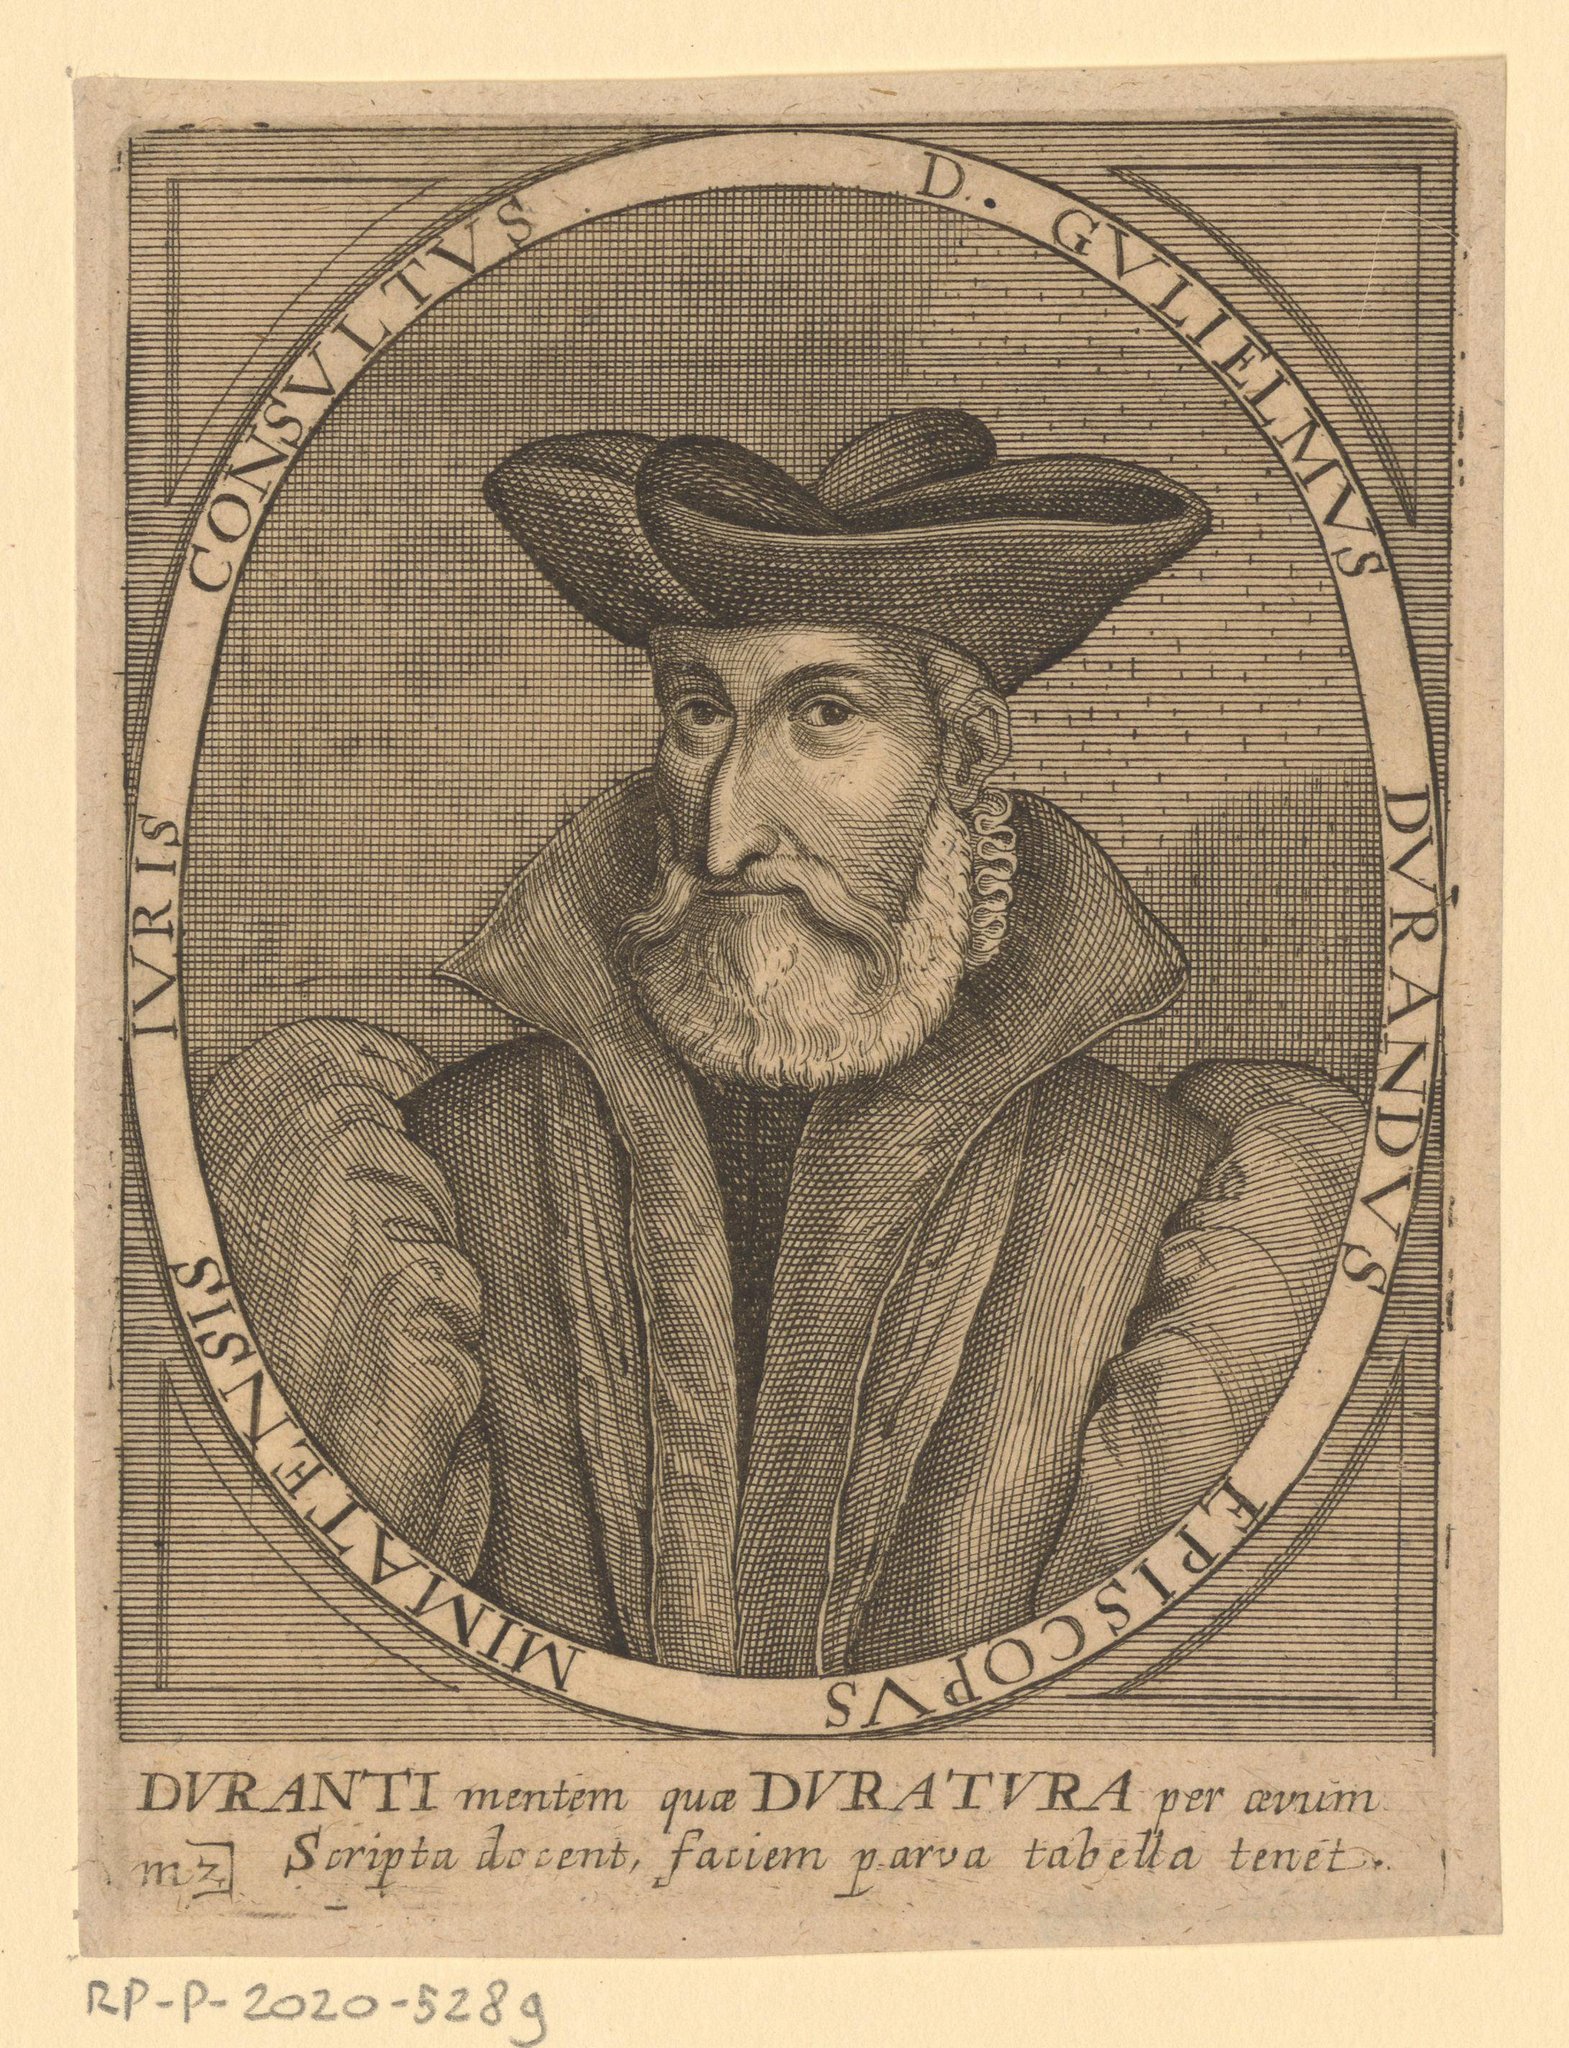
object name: print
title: Portret van Jean-Étienne Duranti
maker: sebastian furck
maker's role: print maker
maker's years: 1600-1655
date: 1650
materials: paper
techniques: engraving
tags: historical persons, politician, e.g. party leader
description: Eerdere staat van prent gebruikt in: Bibliotheca chalcographica. Frankfurt am Main: Johannes Ammon, 1650, dl. 6.